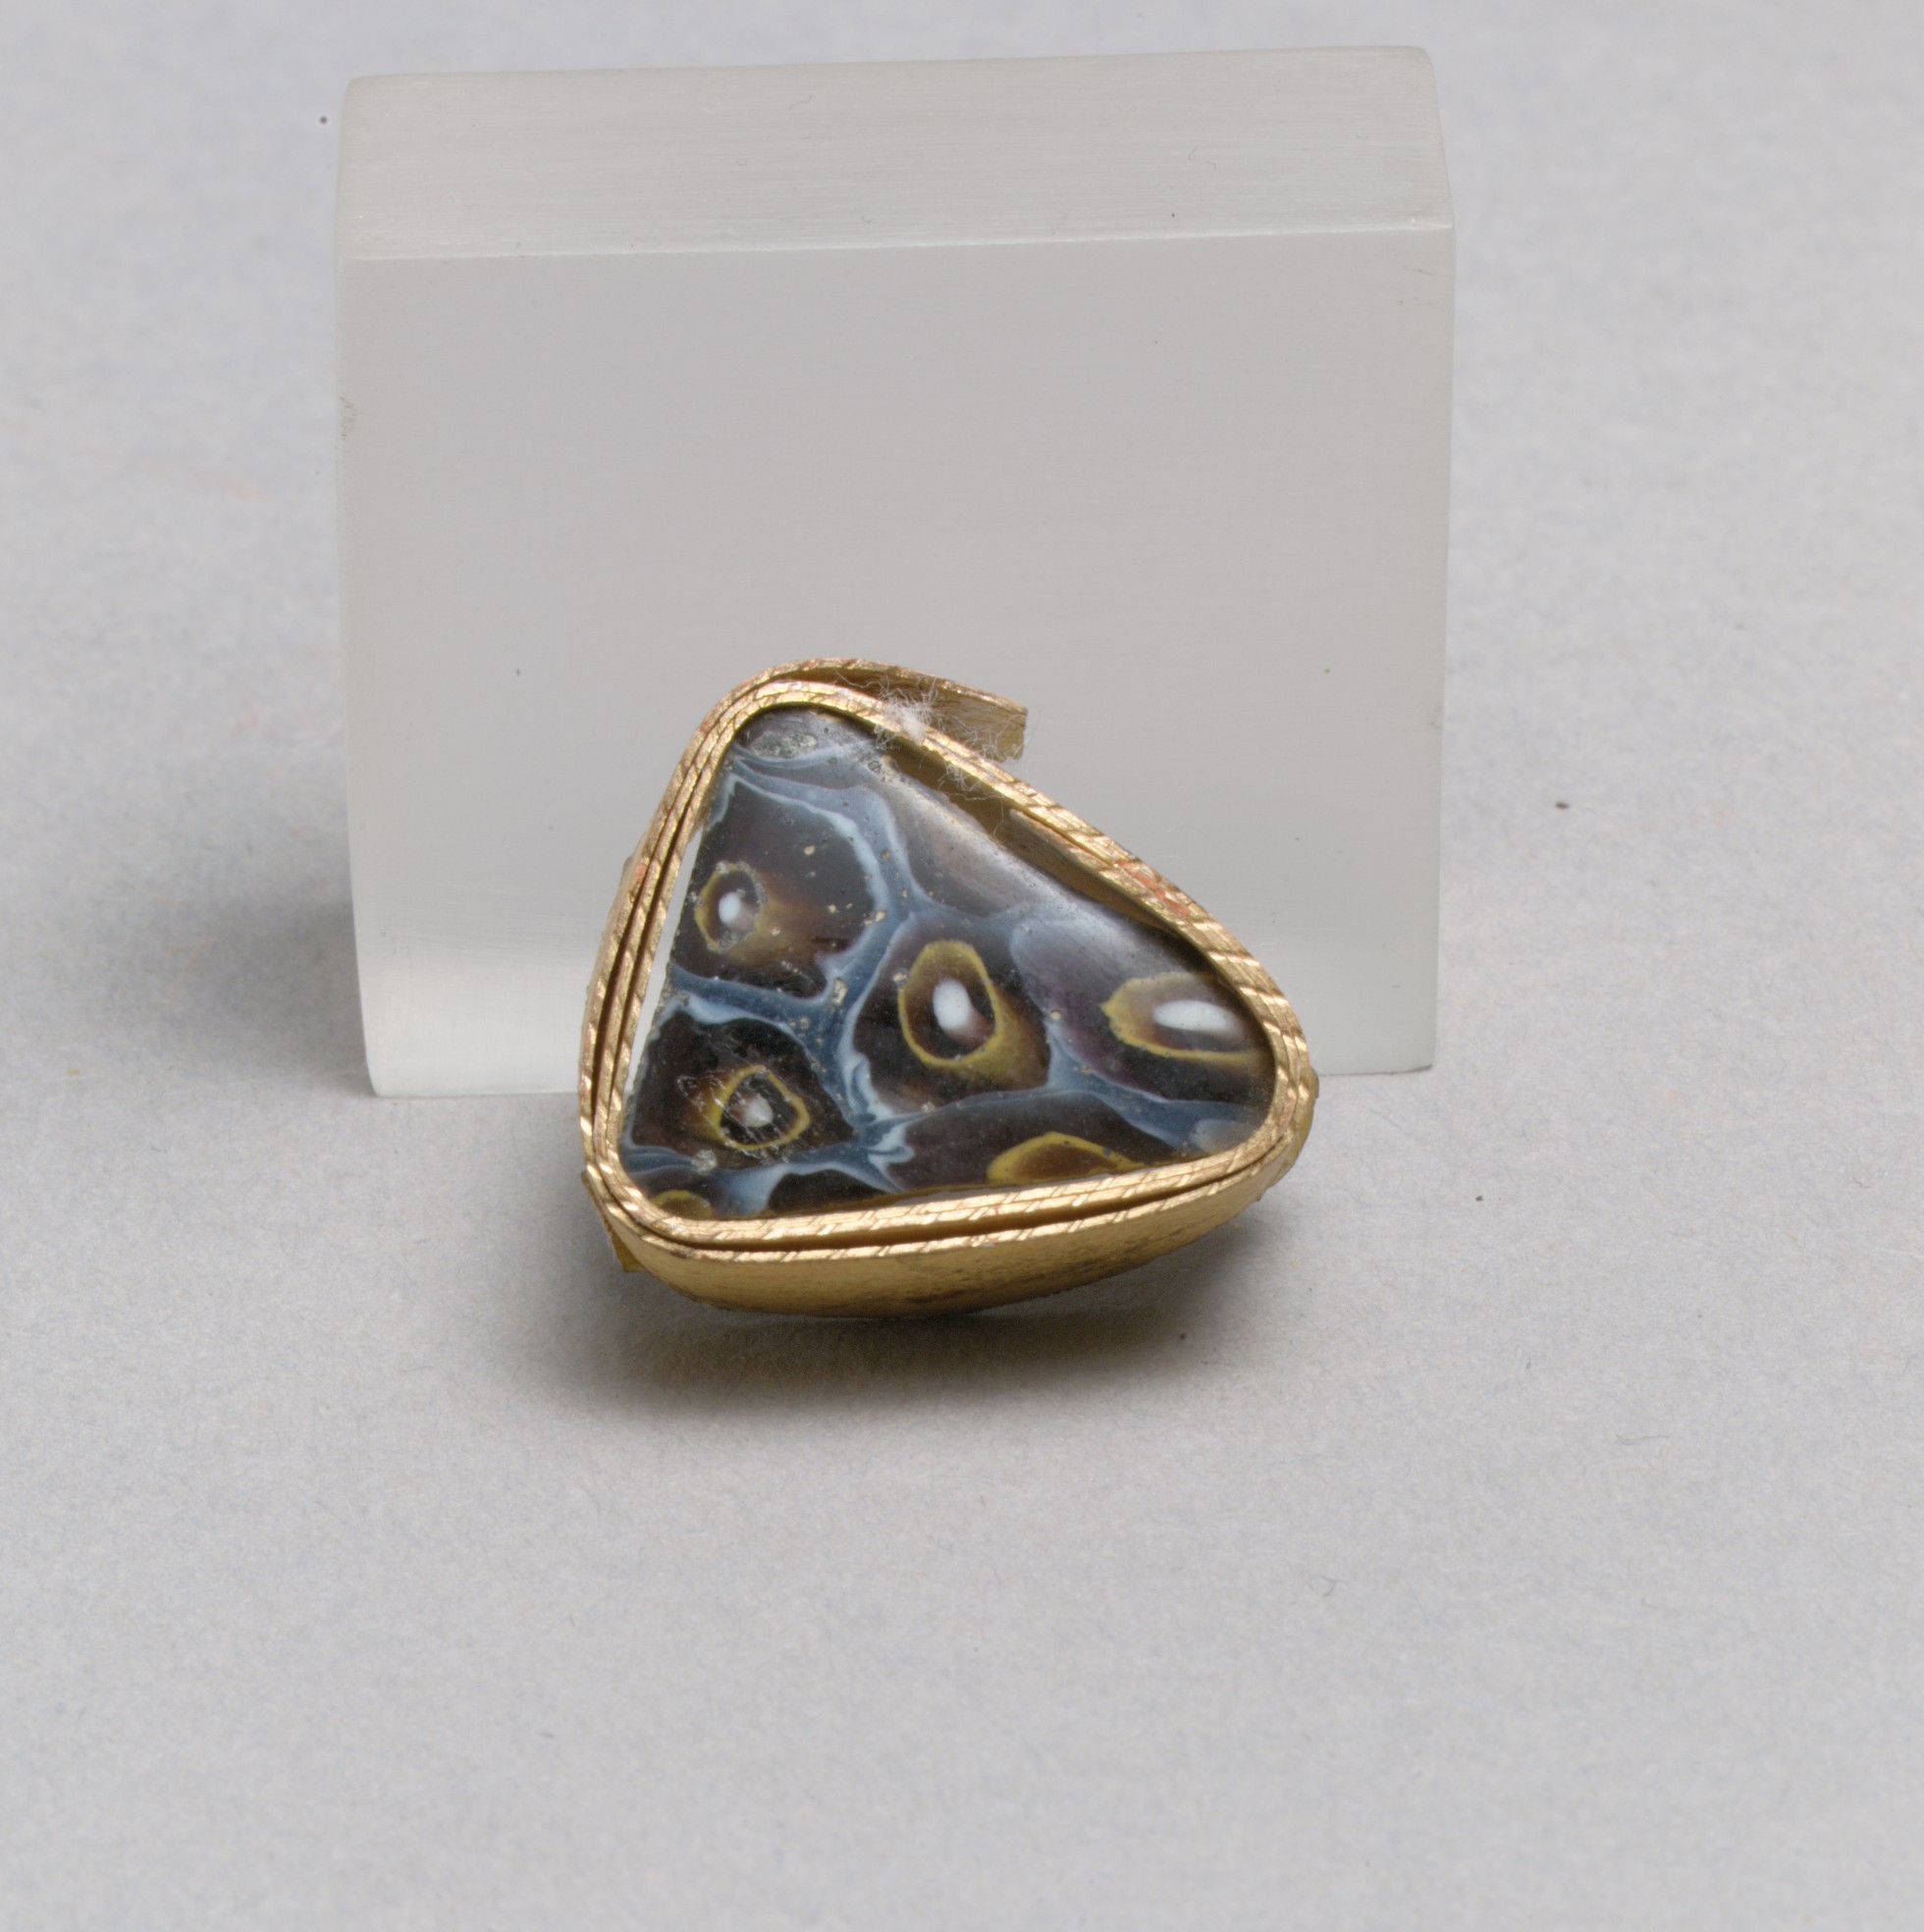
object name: fragment, mosaic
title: Glass mosaic fragment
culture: roman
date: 34 BCE-33 CE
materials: glass